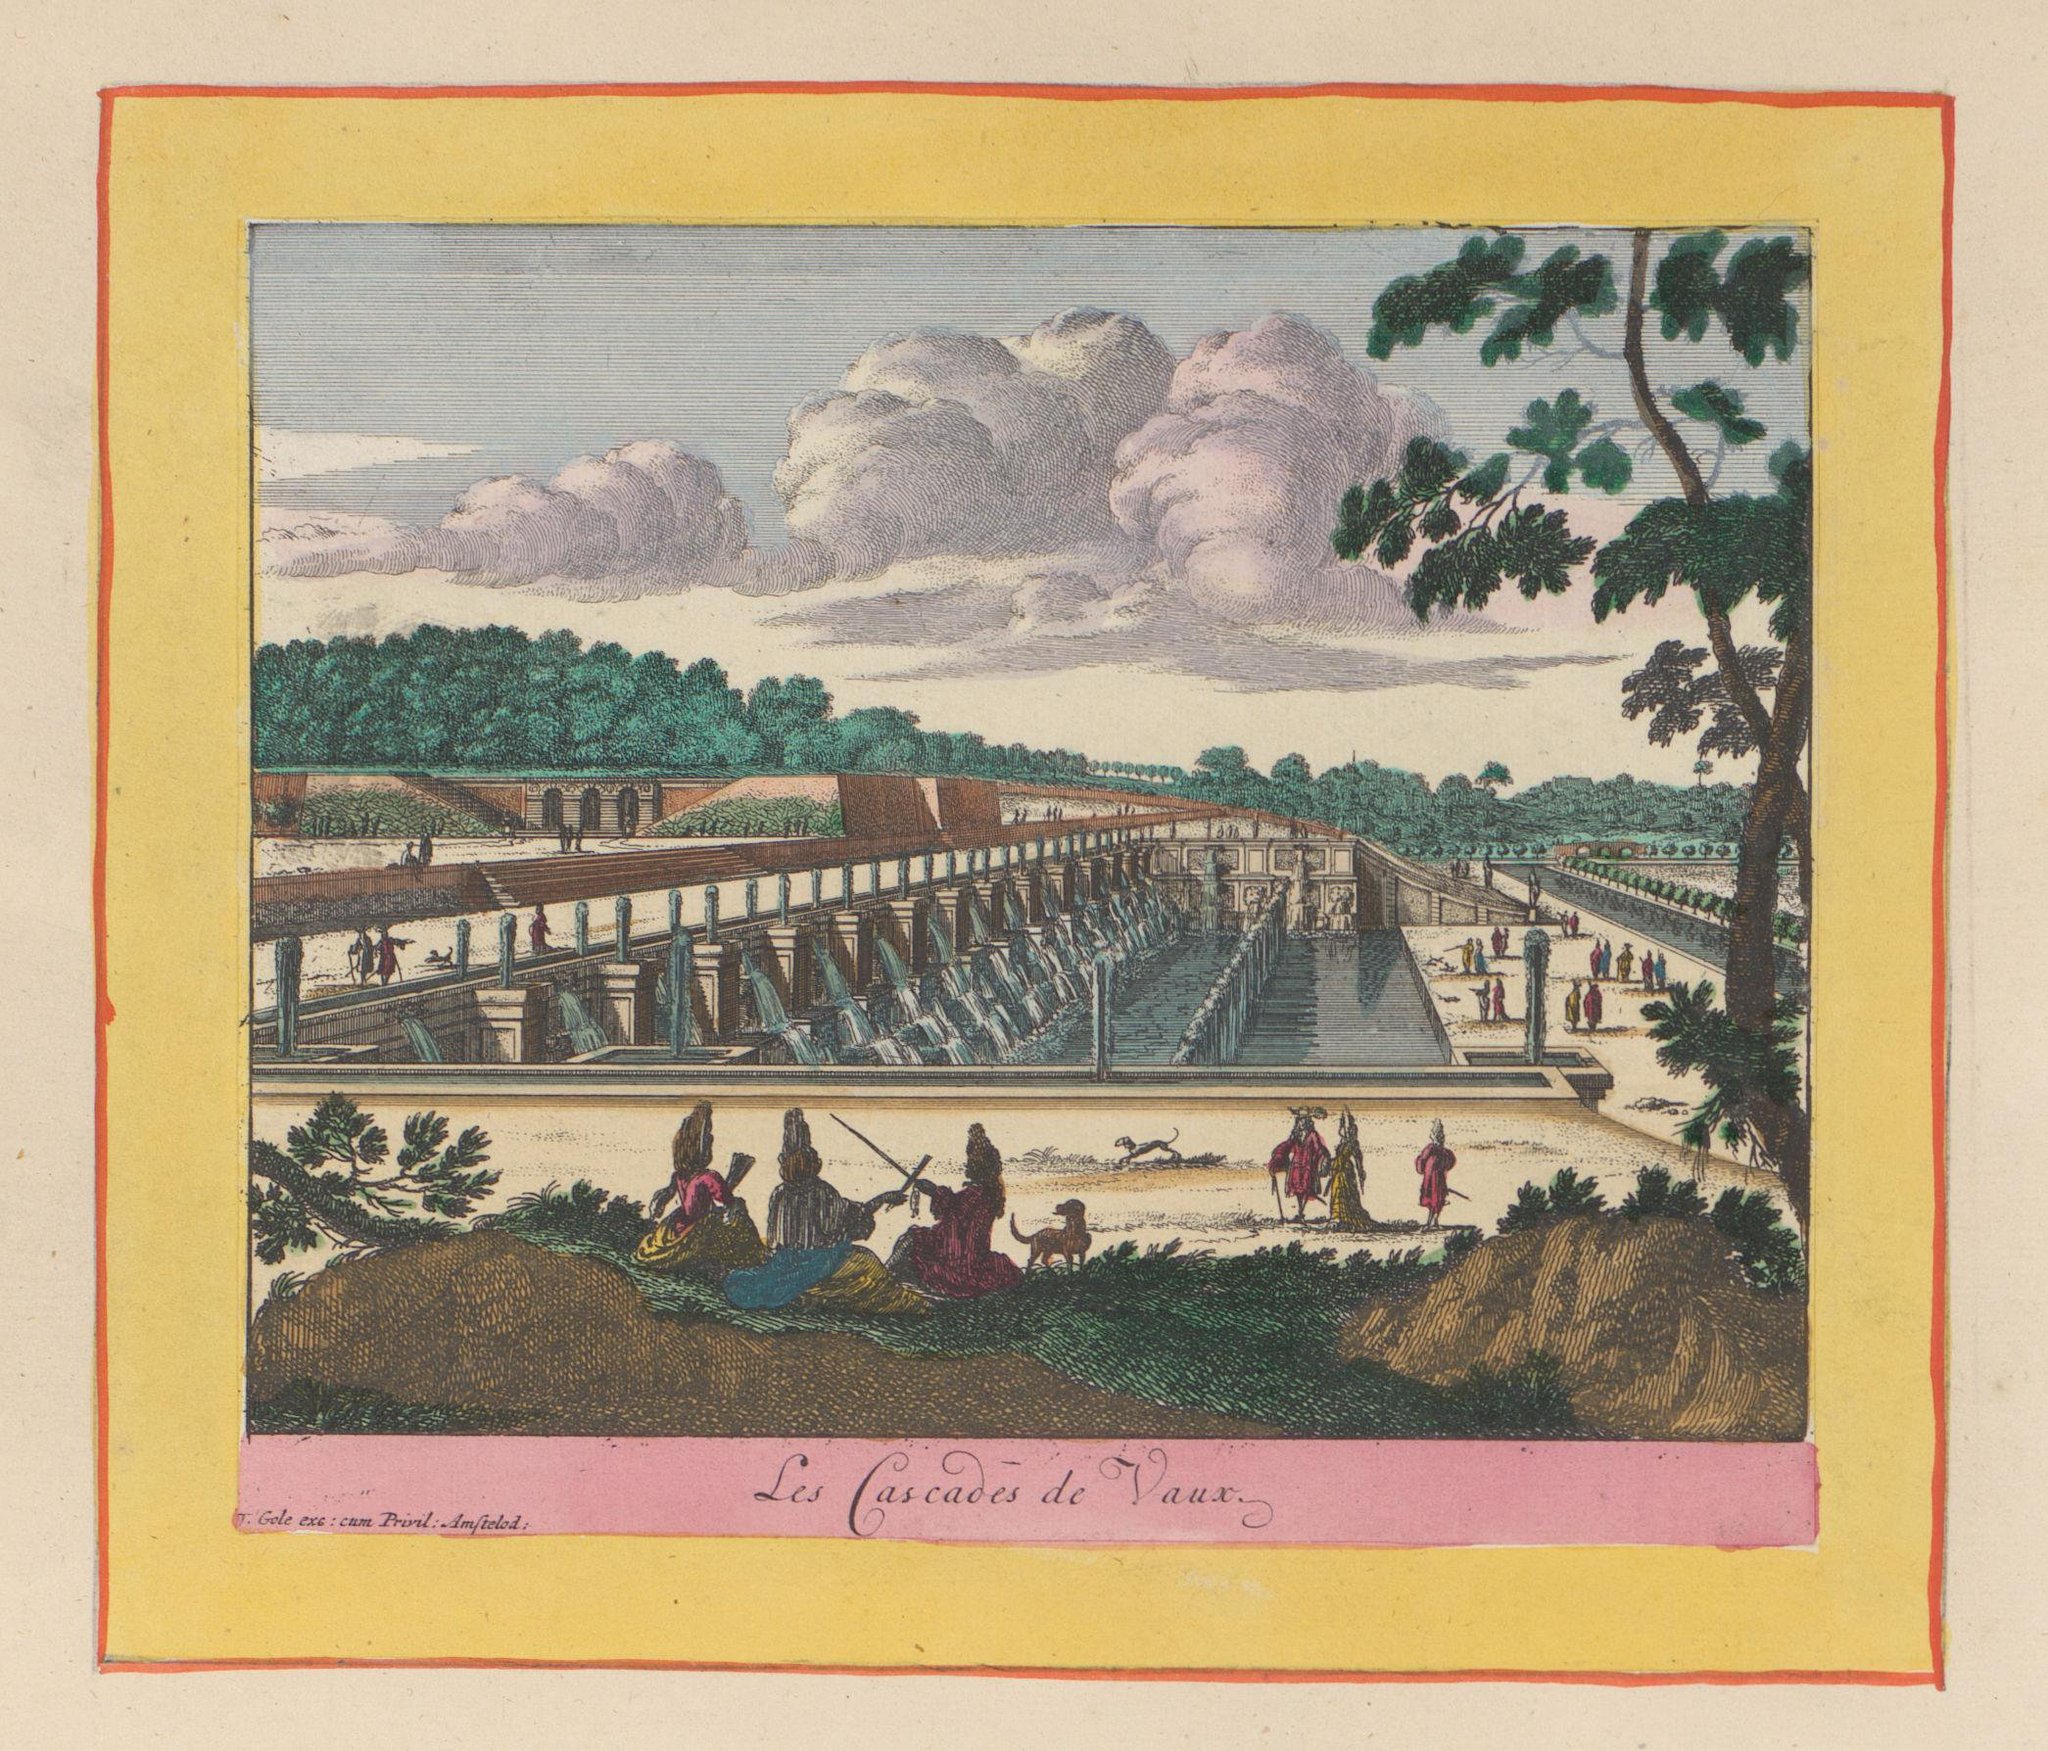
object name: album leaf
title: Gezicht op de cascades in de tuinen van Château de Vaux-le-Vicomte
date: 1681-1724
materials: paper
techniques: etching, hand coloring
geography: northern netherlands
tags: french or architectonic garden; formal garden, garden cascade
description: Gezicht op de cascades in de tuinen van Château de Vaux-le-Vicomte. Op de voorgrond drie zittende figuren en een hond. Prent maakt deel uit van een album.